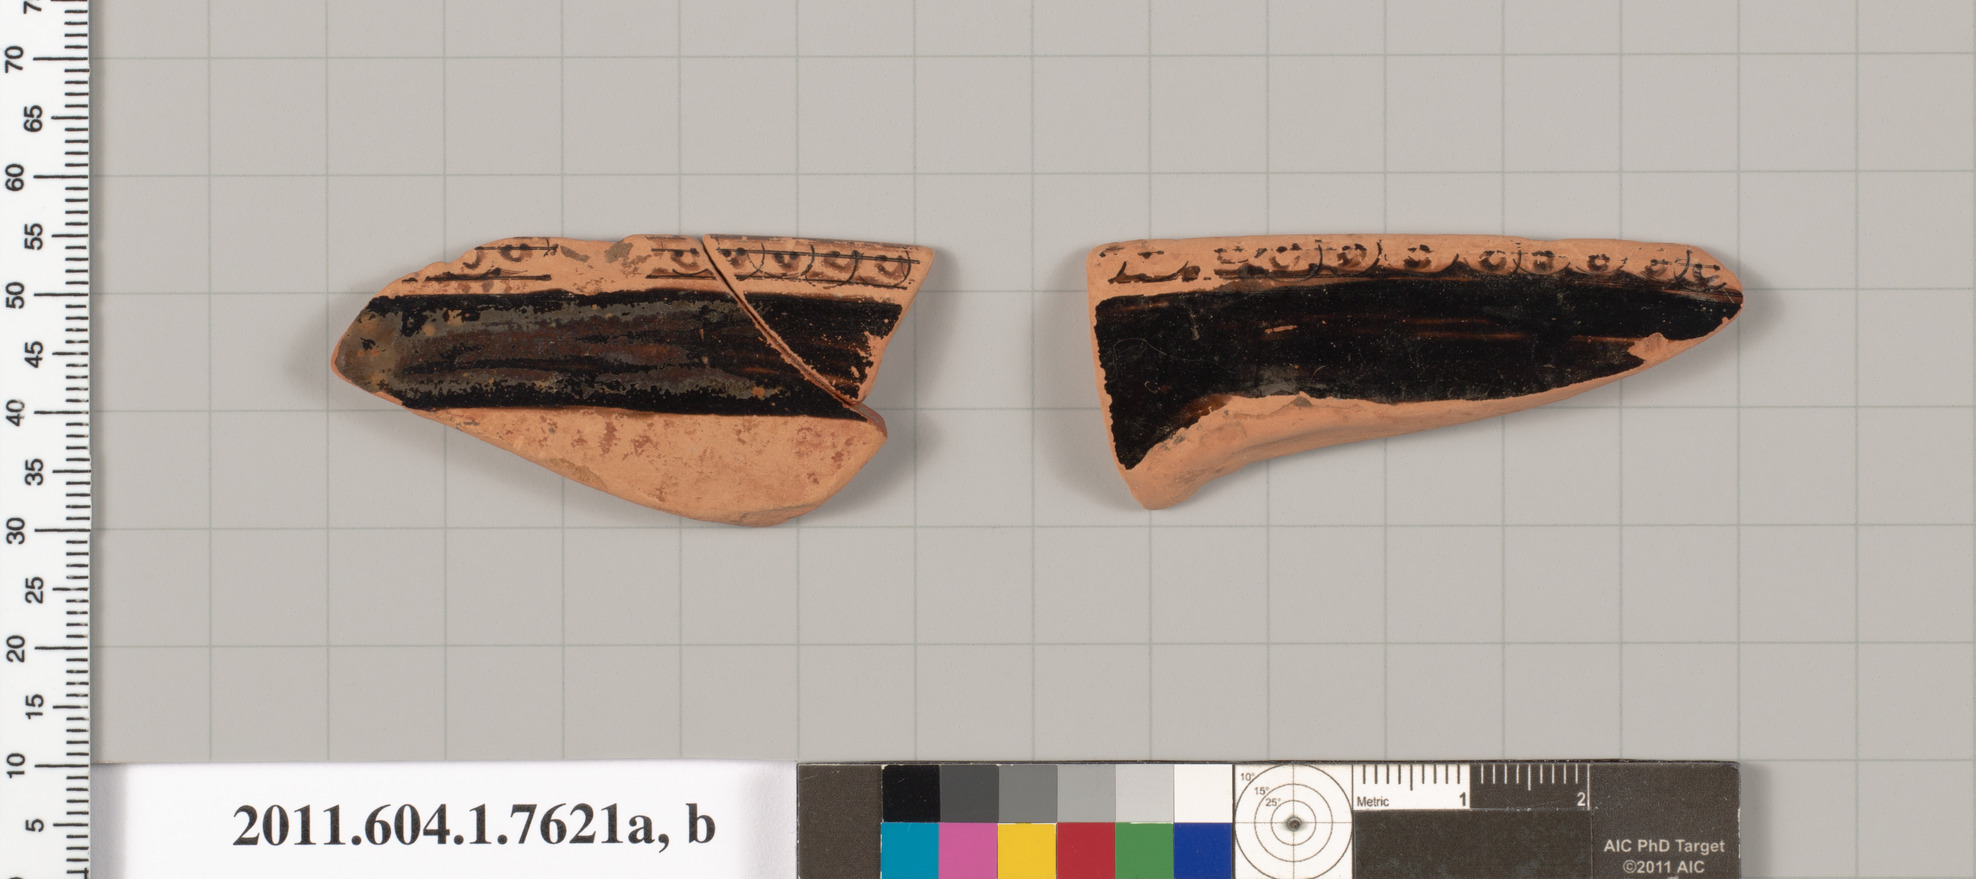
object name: kylix fragment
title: Terracotta rim fragments of a kylix (drinking cup)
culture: greek, attic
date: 460-450 BCE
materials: terracotta